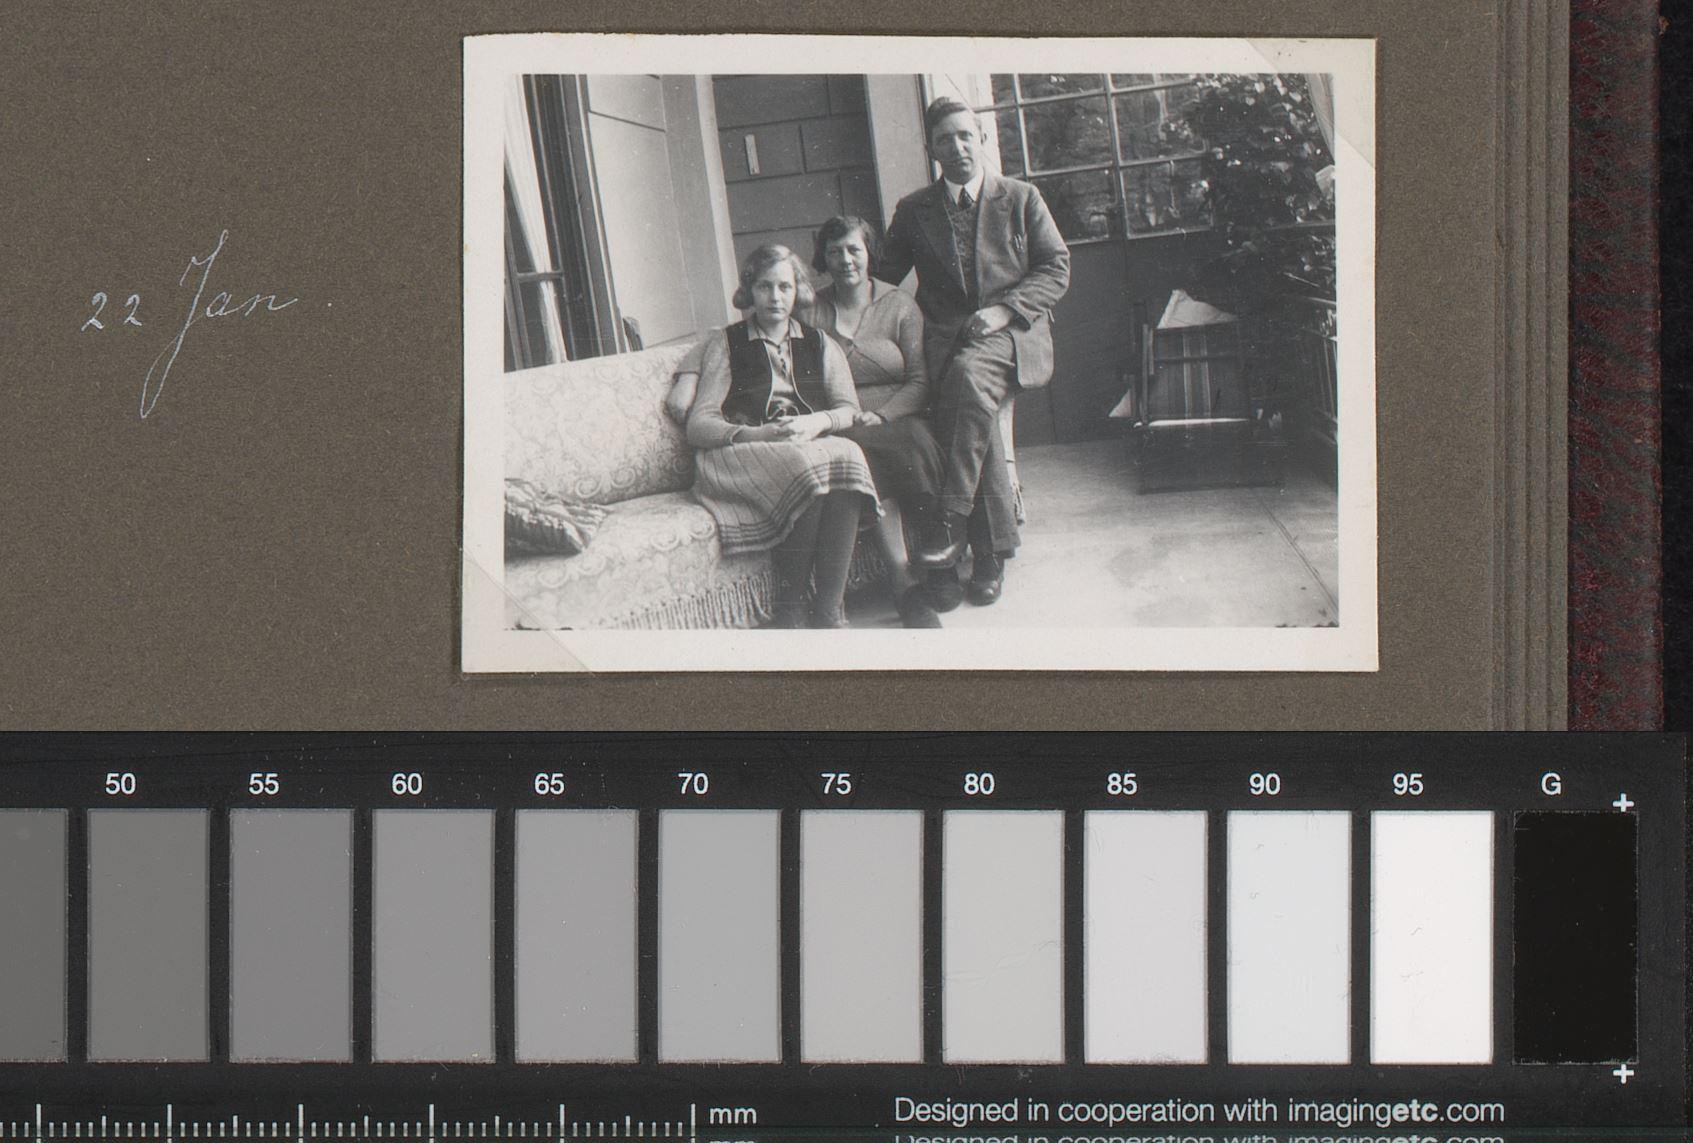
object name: album leaf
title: Familie Streekstra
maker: Anonymous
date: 1934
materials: photographic support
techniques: gelatin silver print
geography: switzerland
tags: family group, especially parents with their child(ren), historical persons, couch, sofa, settee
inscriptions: number: ‘65’